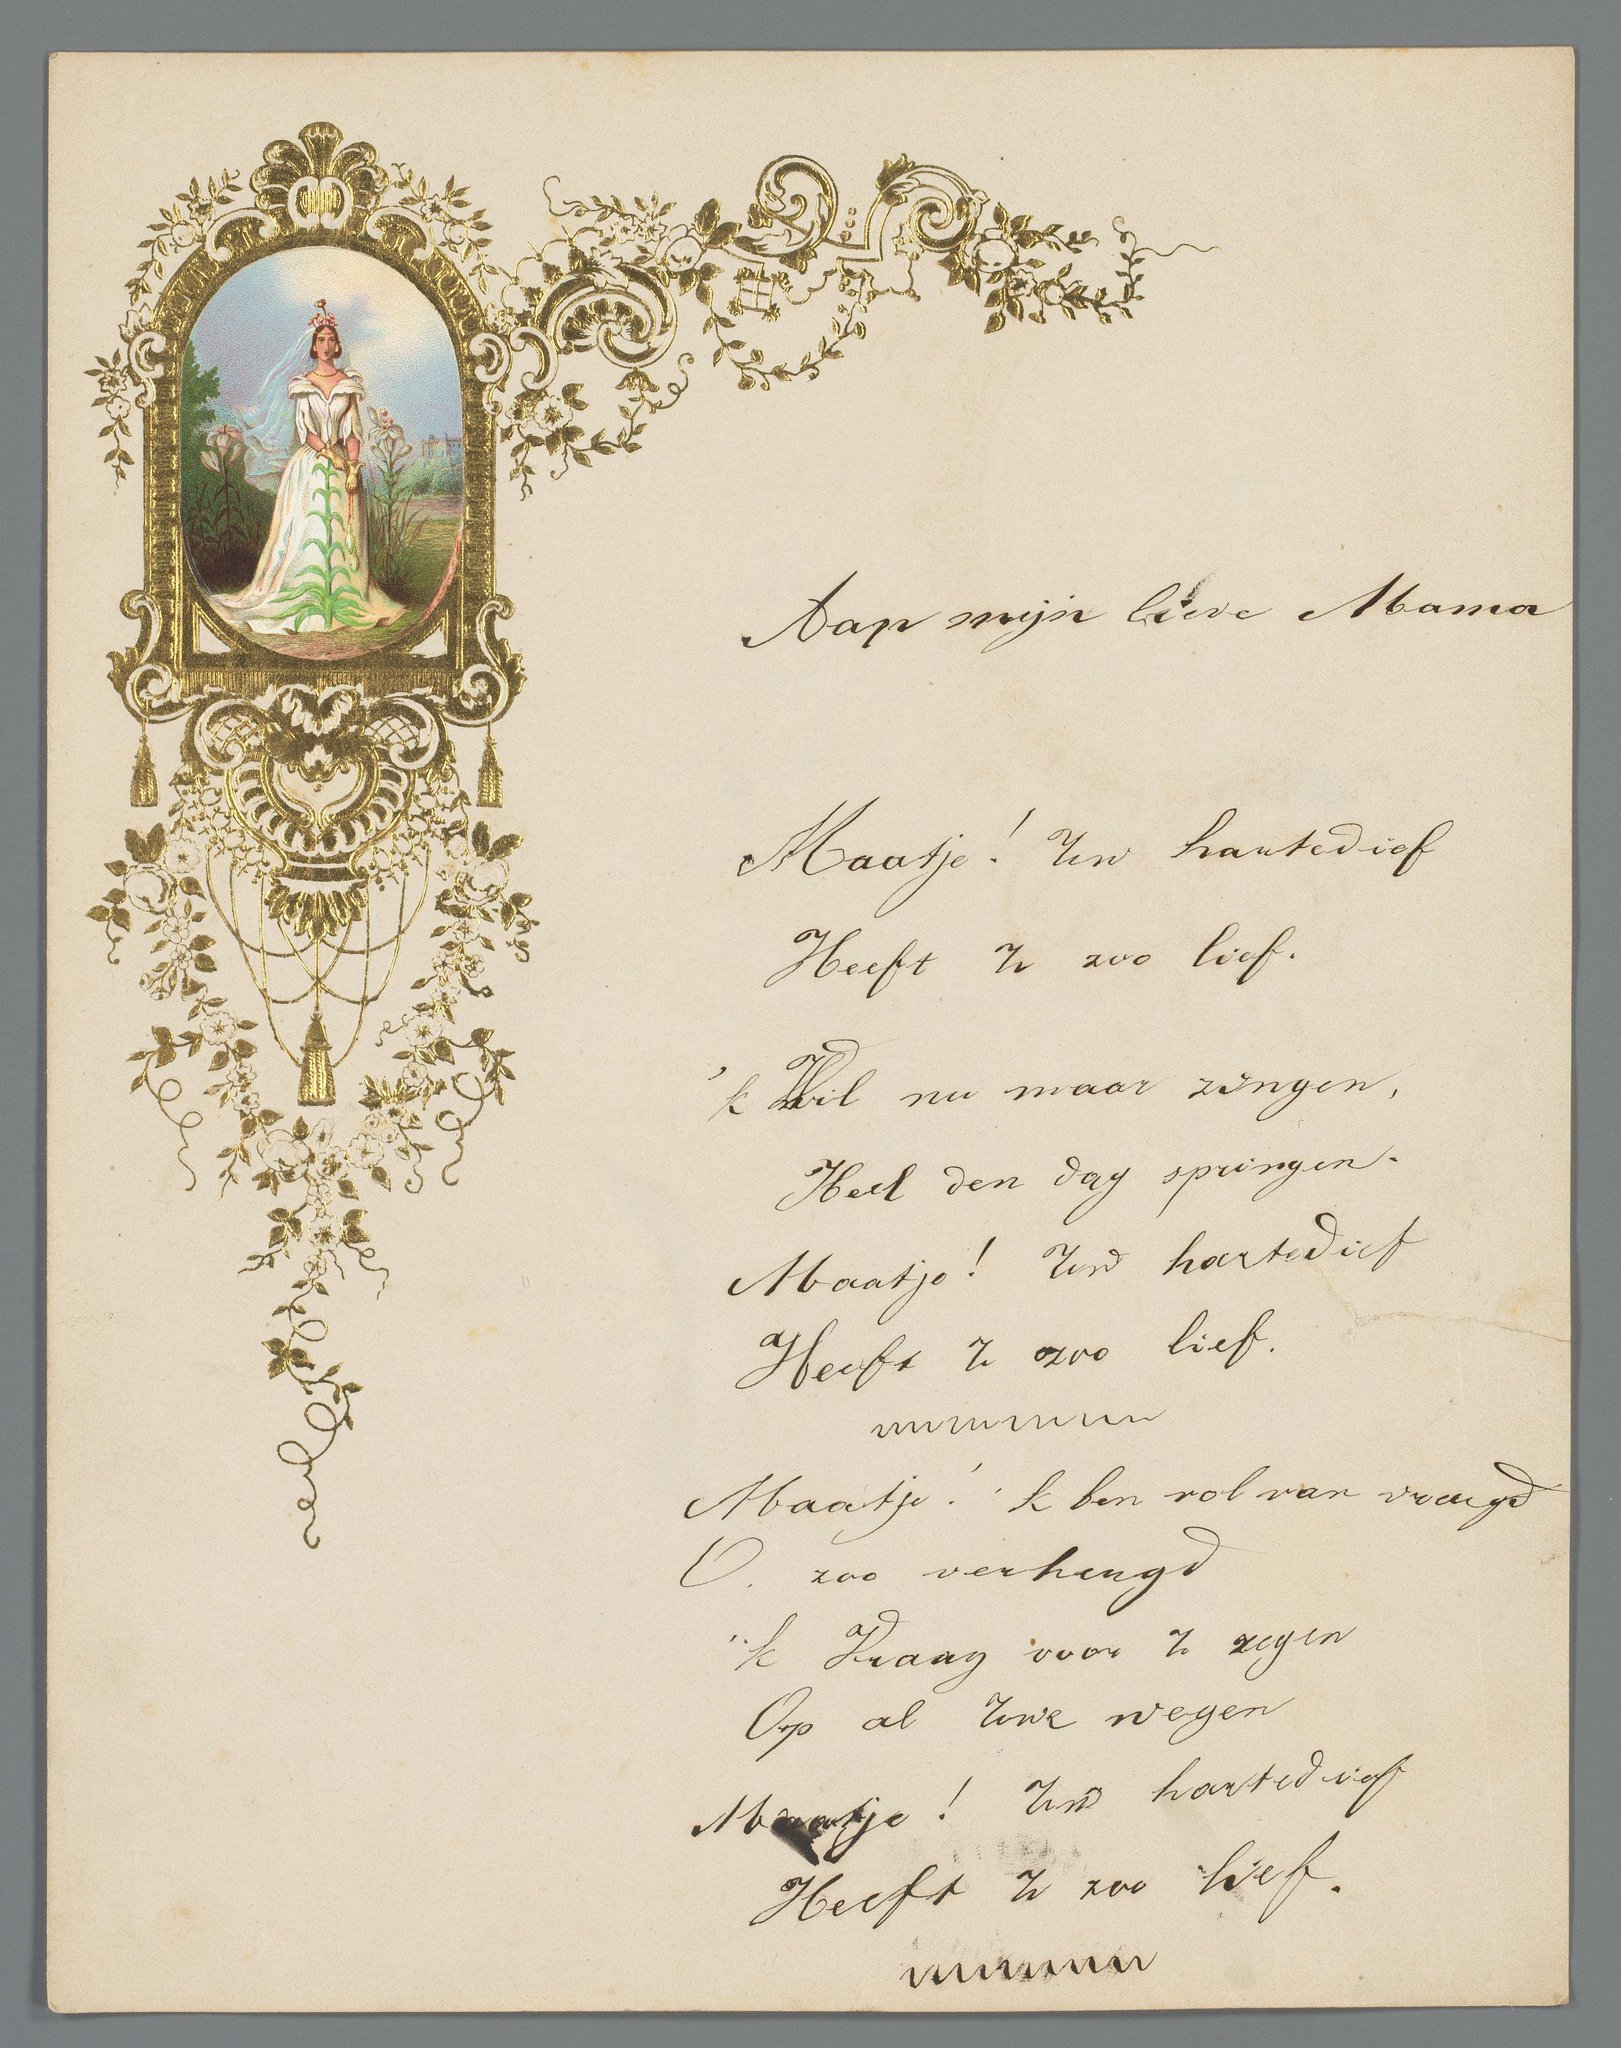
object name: greeting card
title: Gelukwens ter ere van de verjaardag van Eldine Aldegonda Gaymans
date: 1881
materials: ink, paper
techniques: printing, lithograph, letterpress printing, pen, writing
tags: haarlem, the hague, politician, eeltjo aldegondus van beresteijn, birthday, adult woman, flowers: lily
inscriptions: date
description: Handgeschreven verjaardagswens van Eeltjo van Beresteijn aan zijn moeder, Eldine Aldegonda Gaymans. Op de voorzijde een decoratief kader in de linker- en bovenmarge. Linksboven een ovaal met daarop een statige vrouw tussen lelies.